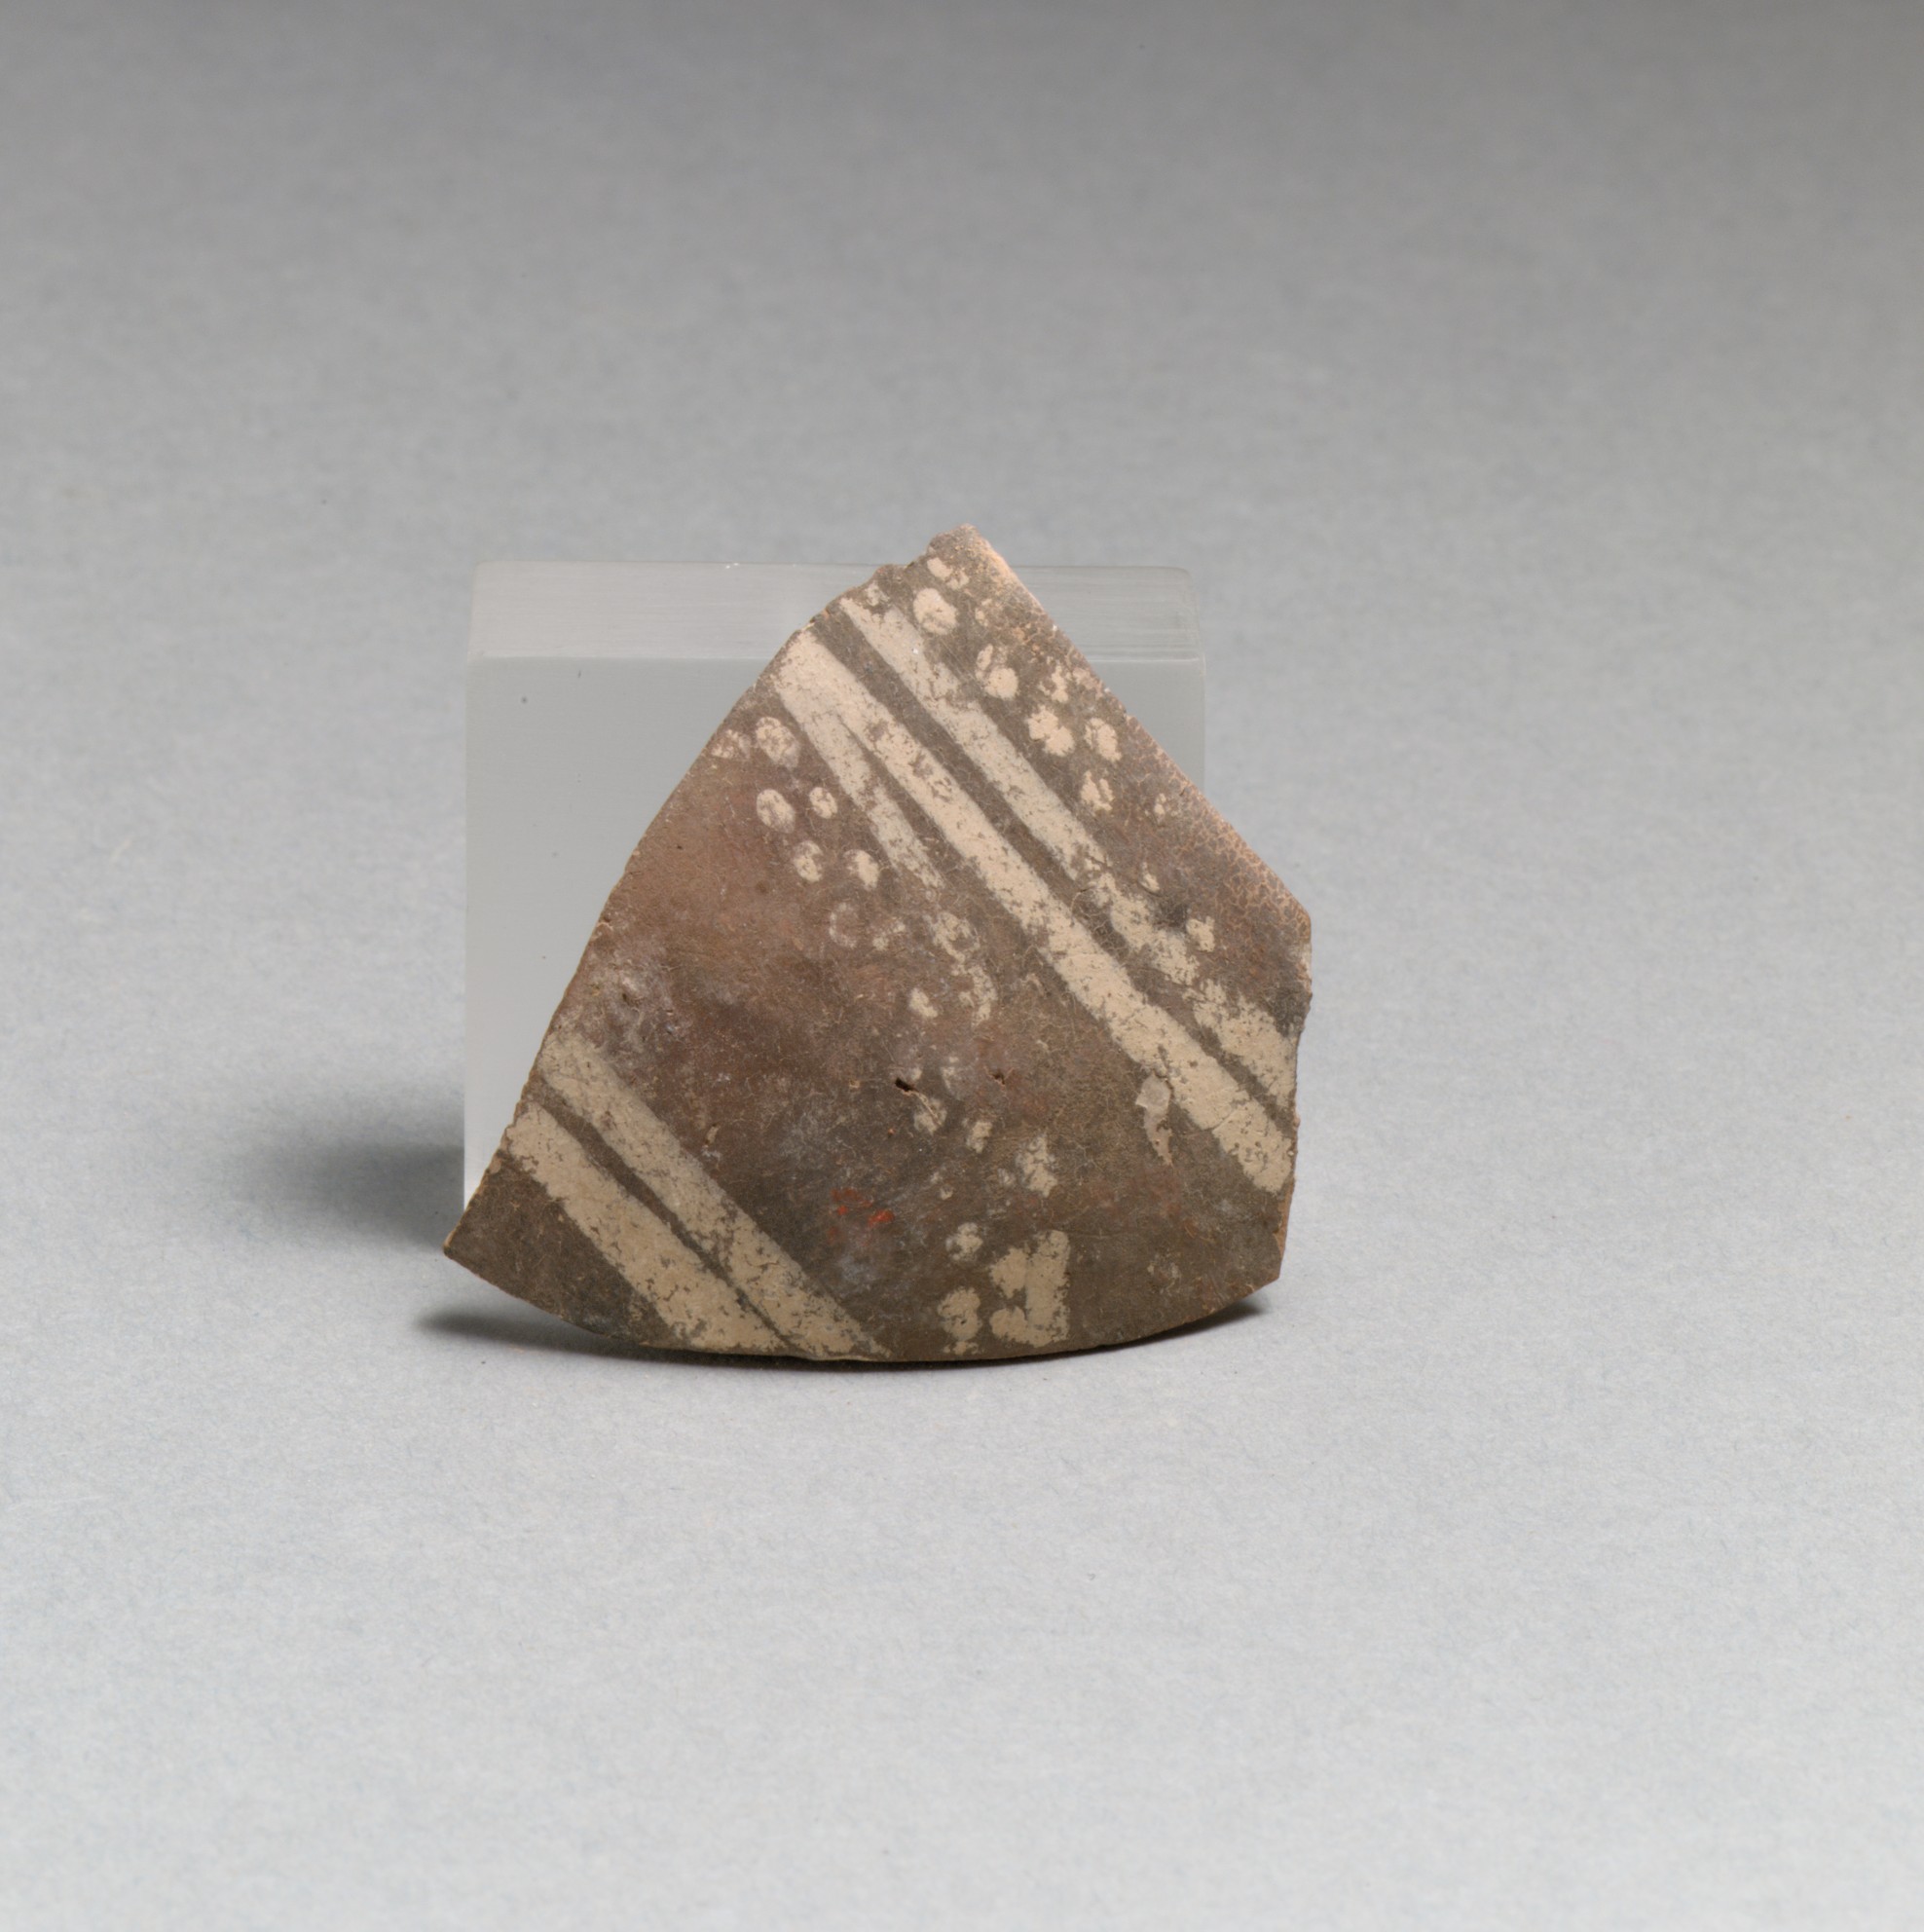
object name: vase fragment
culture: minoan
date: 2600-2000 BCE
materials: terracotta